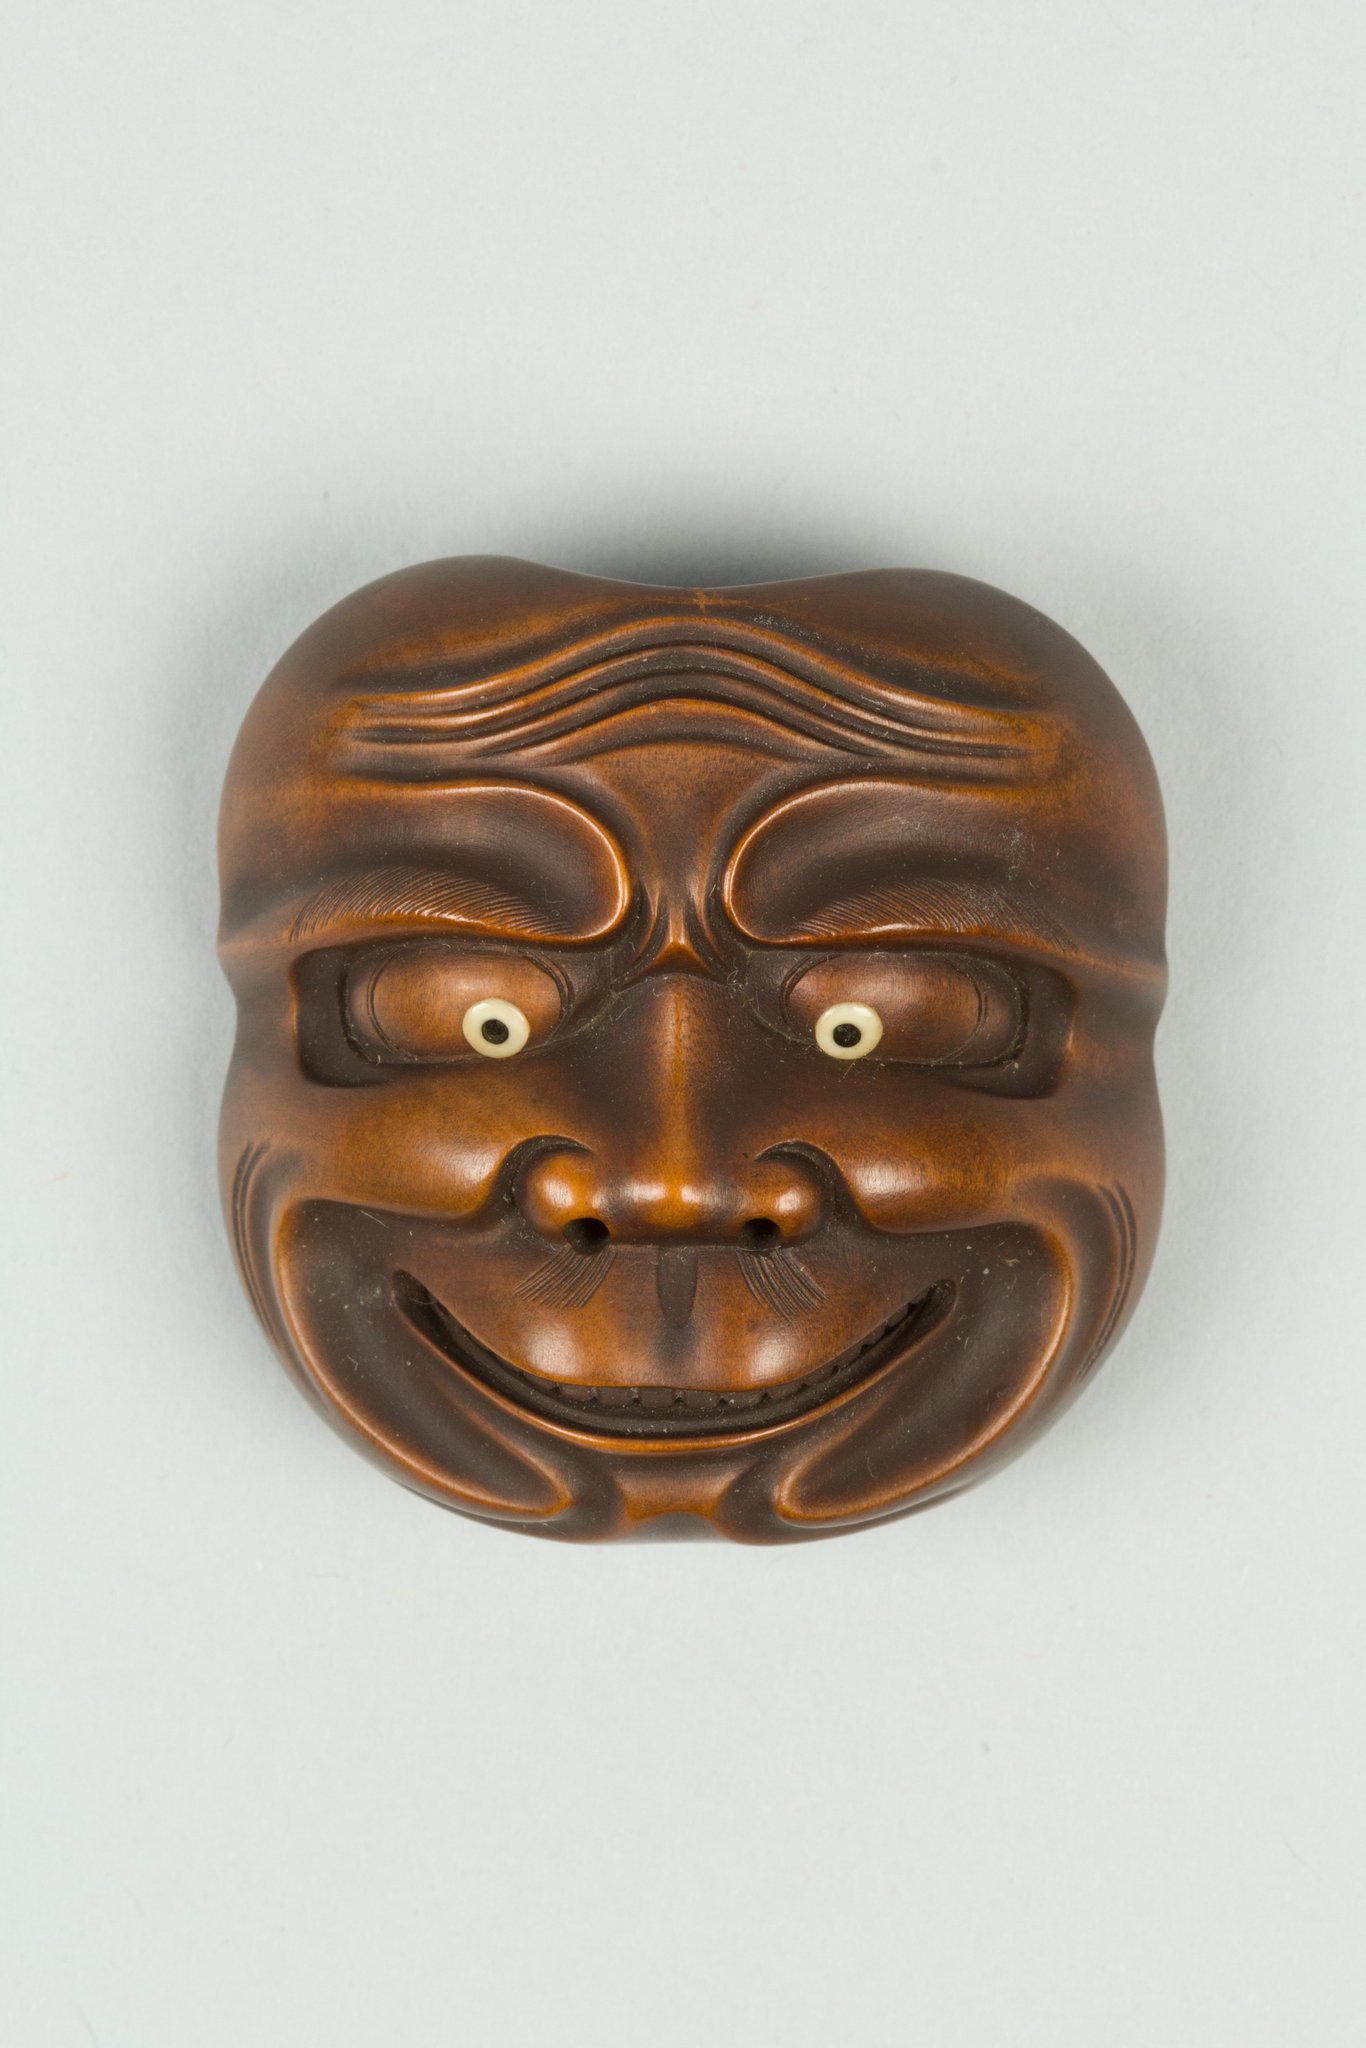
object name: netsuke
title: Netsuke of Noh Mask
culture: japanese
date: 1801-1900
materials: wood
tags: masks